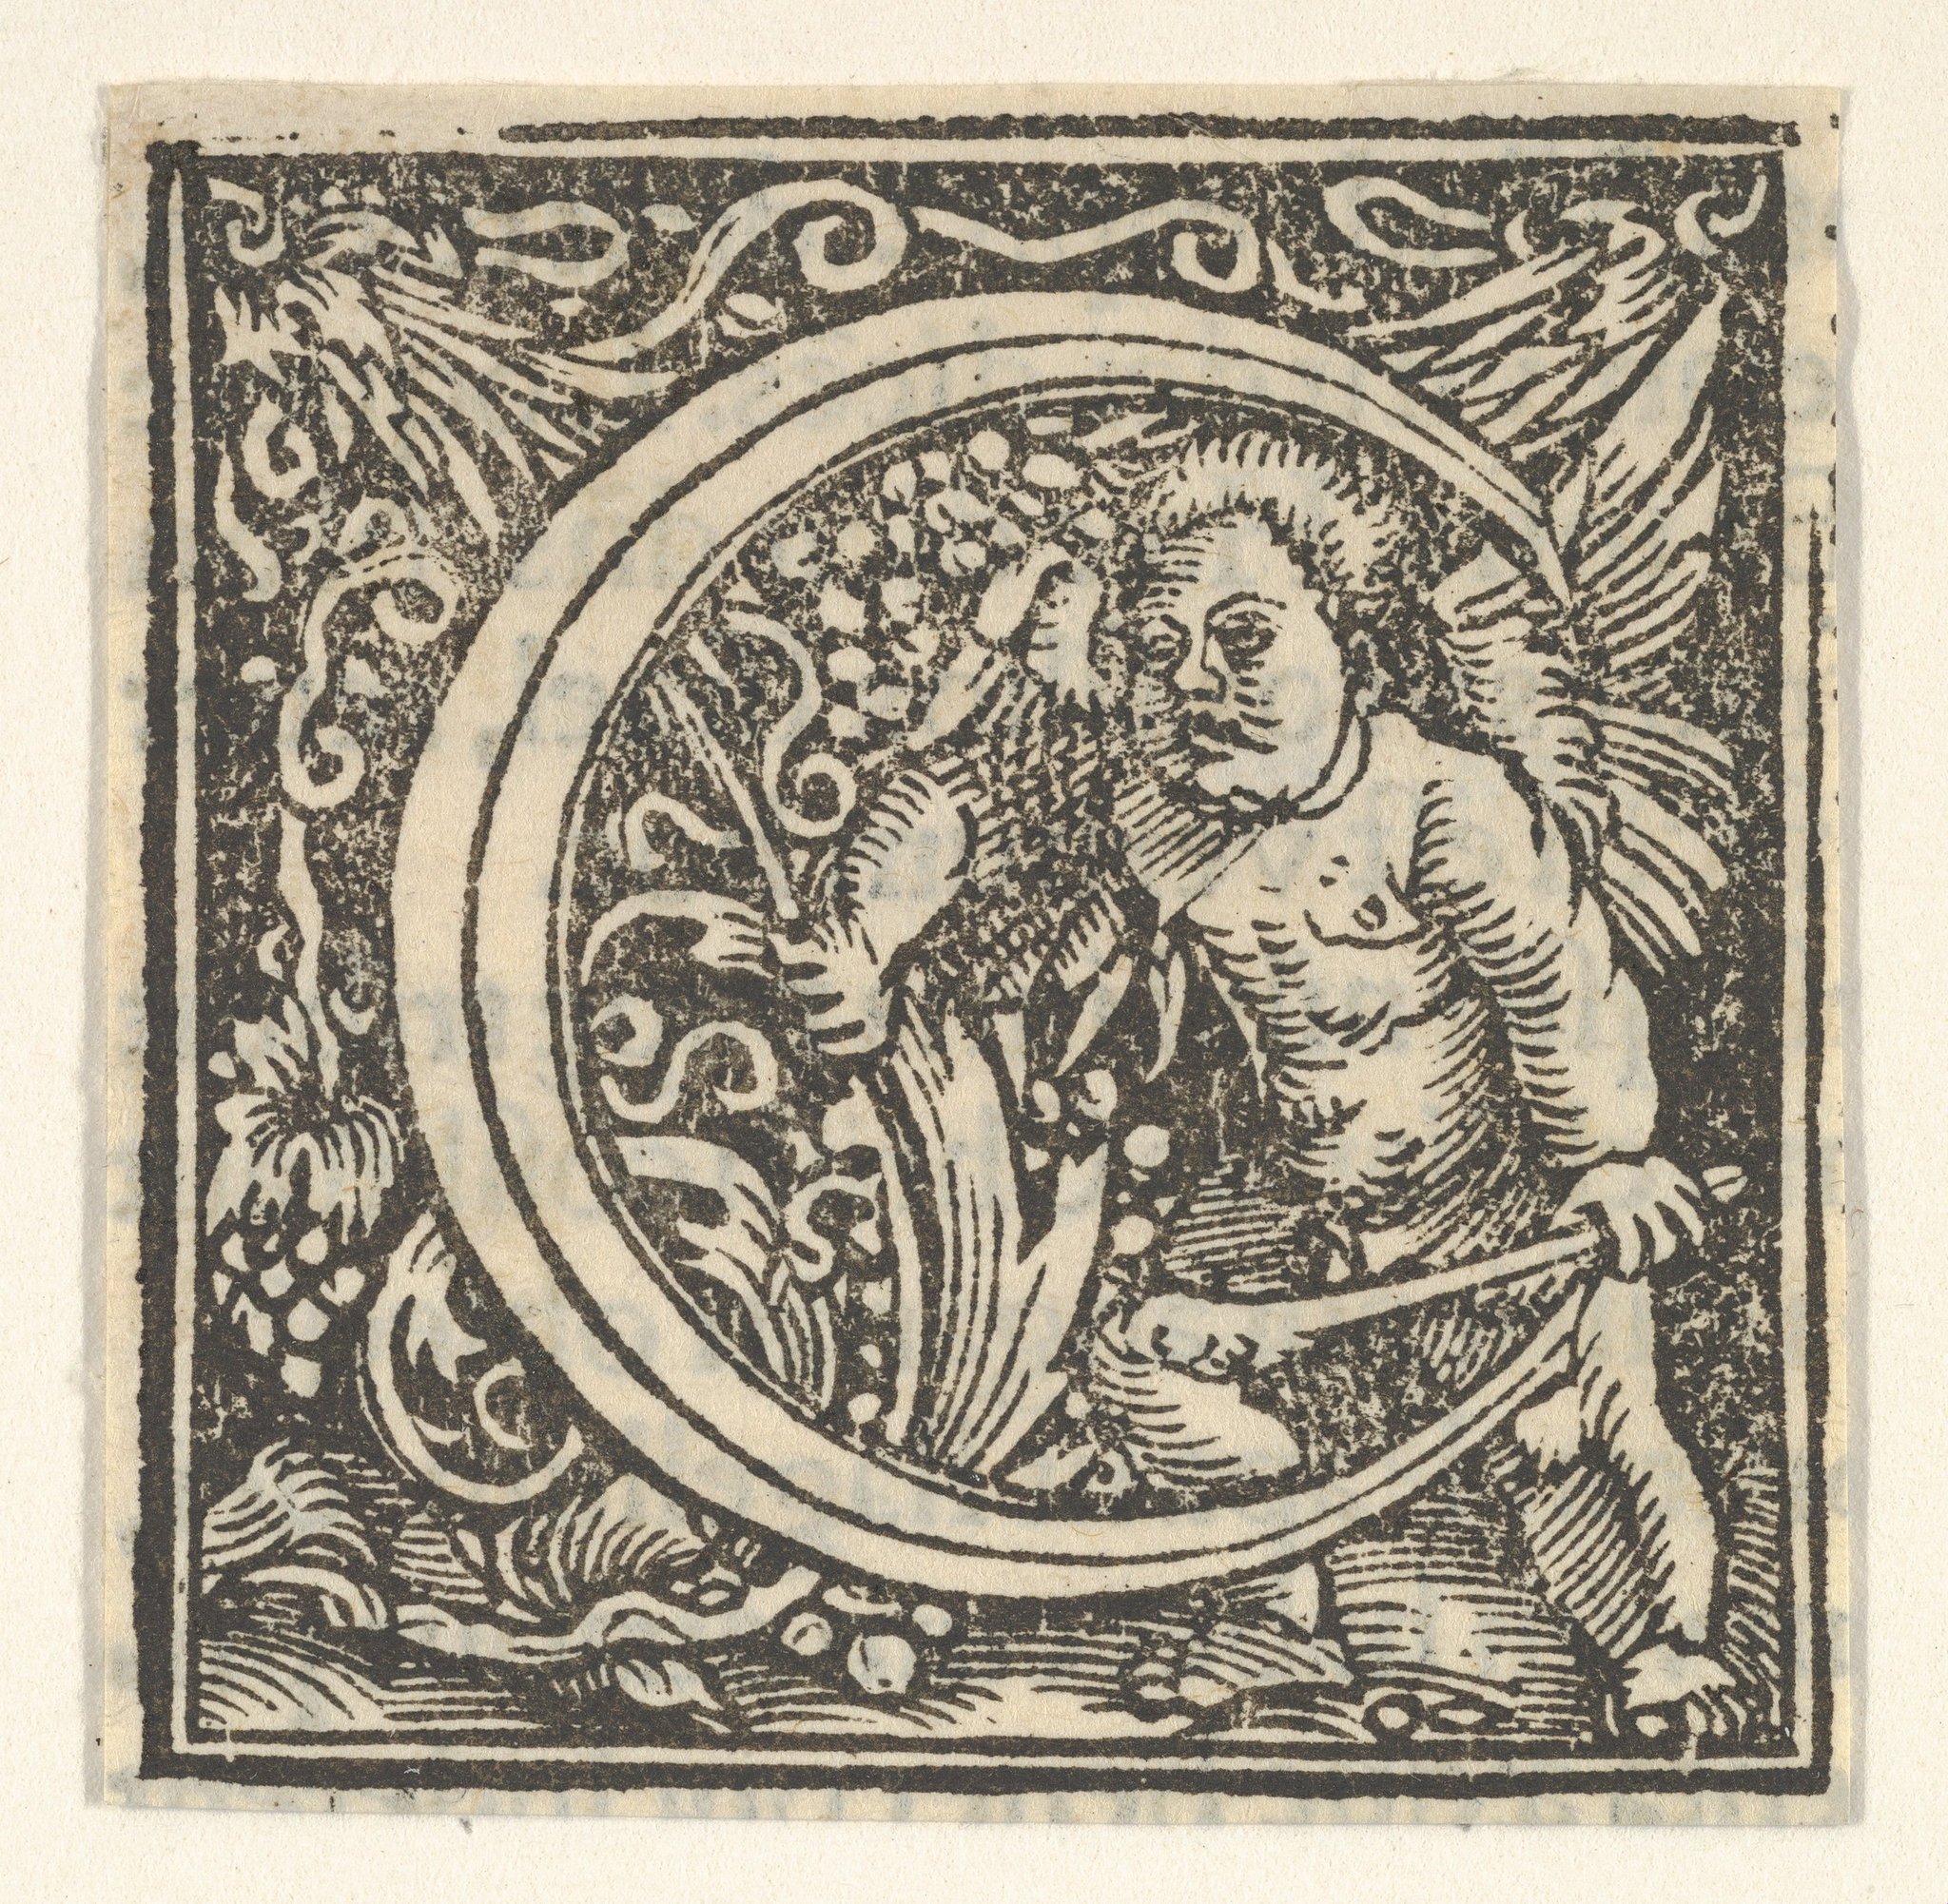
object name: print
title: Initial letter C with putto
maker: heinrich vogtherr the elder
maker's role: artist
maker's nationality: german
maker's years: 1538-1540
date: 1538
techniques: woodcut